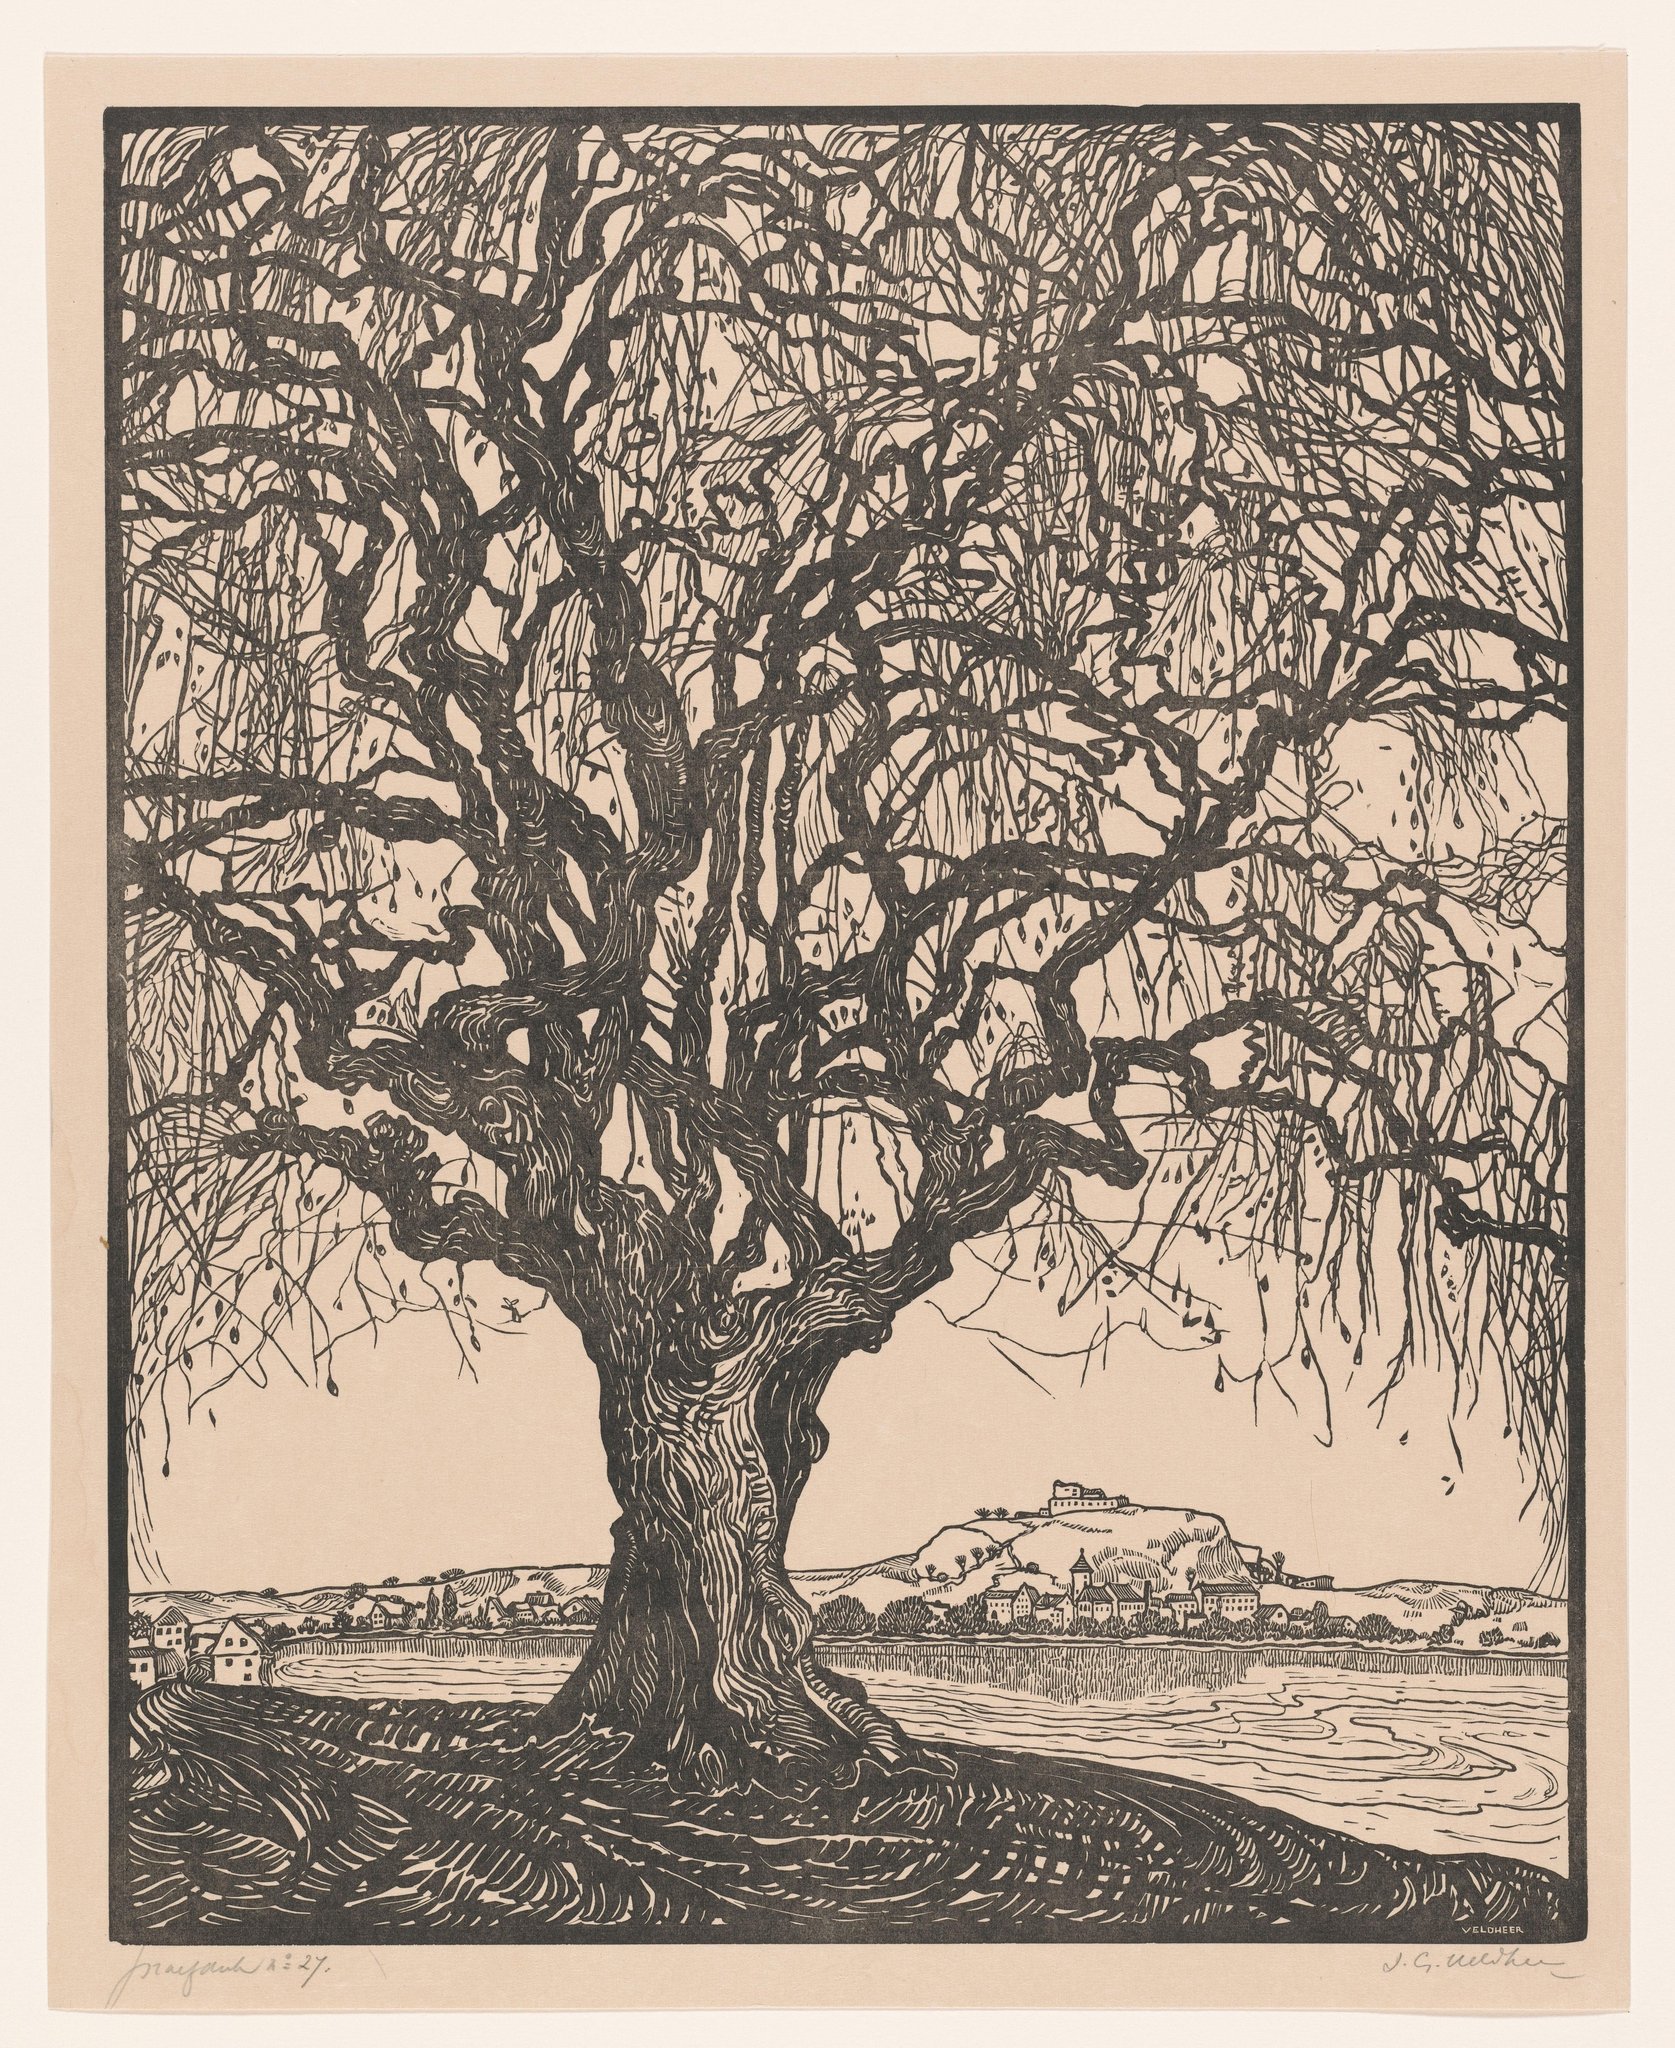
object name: print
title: Boom aan een rivier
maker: jacobus gerardus veldheer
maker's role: draughtsman, print maker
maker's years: 1866-1954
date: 1876-1916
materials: paper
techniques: woodcut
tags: trees, river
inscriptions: number: ‘no. 27’, collector's mark: Lugt 2233